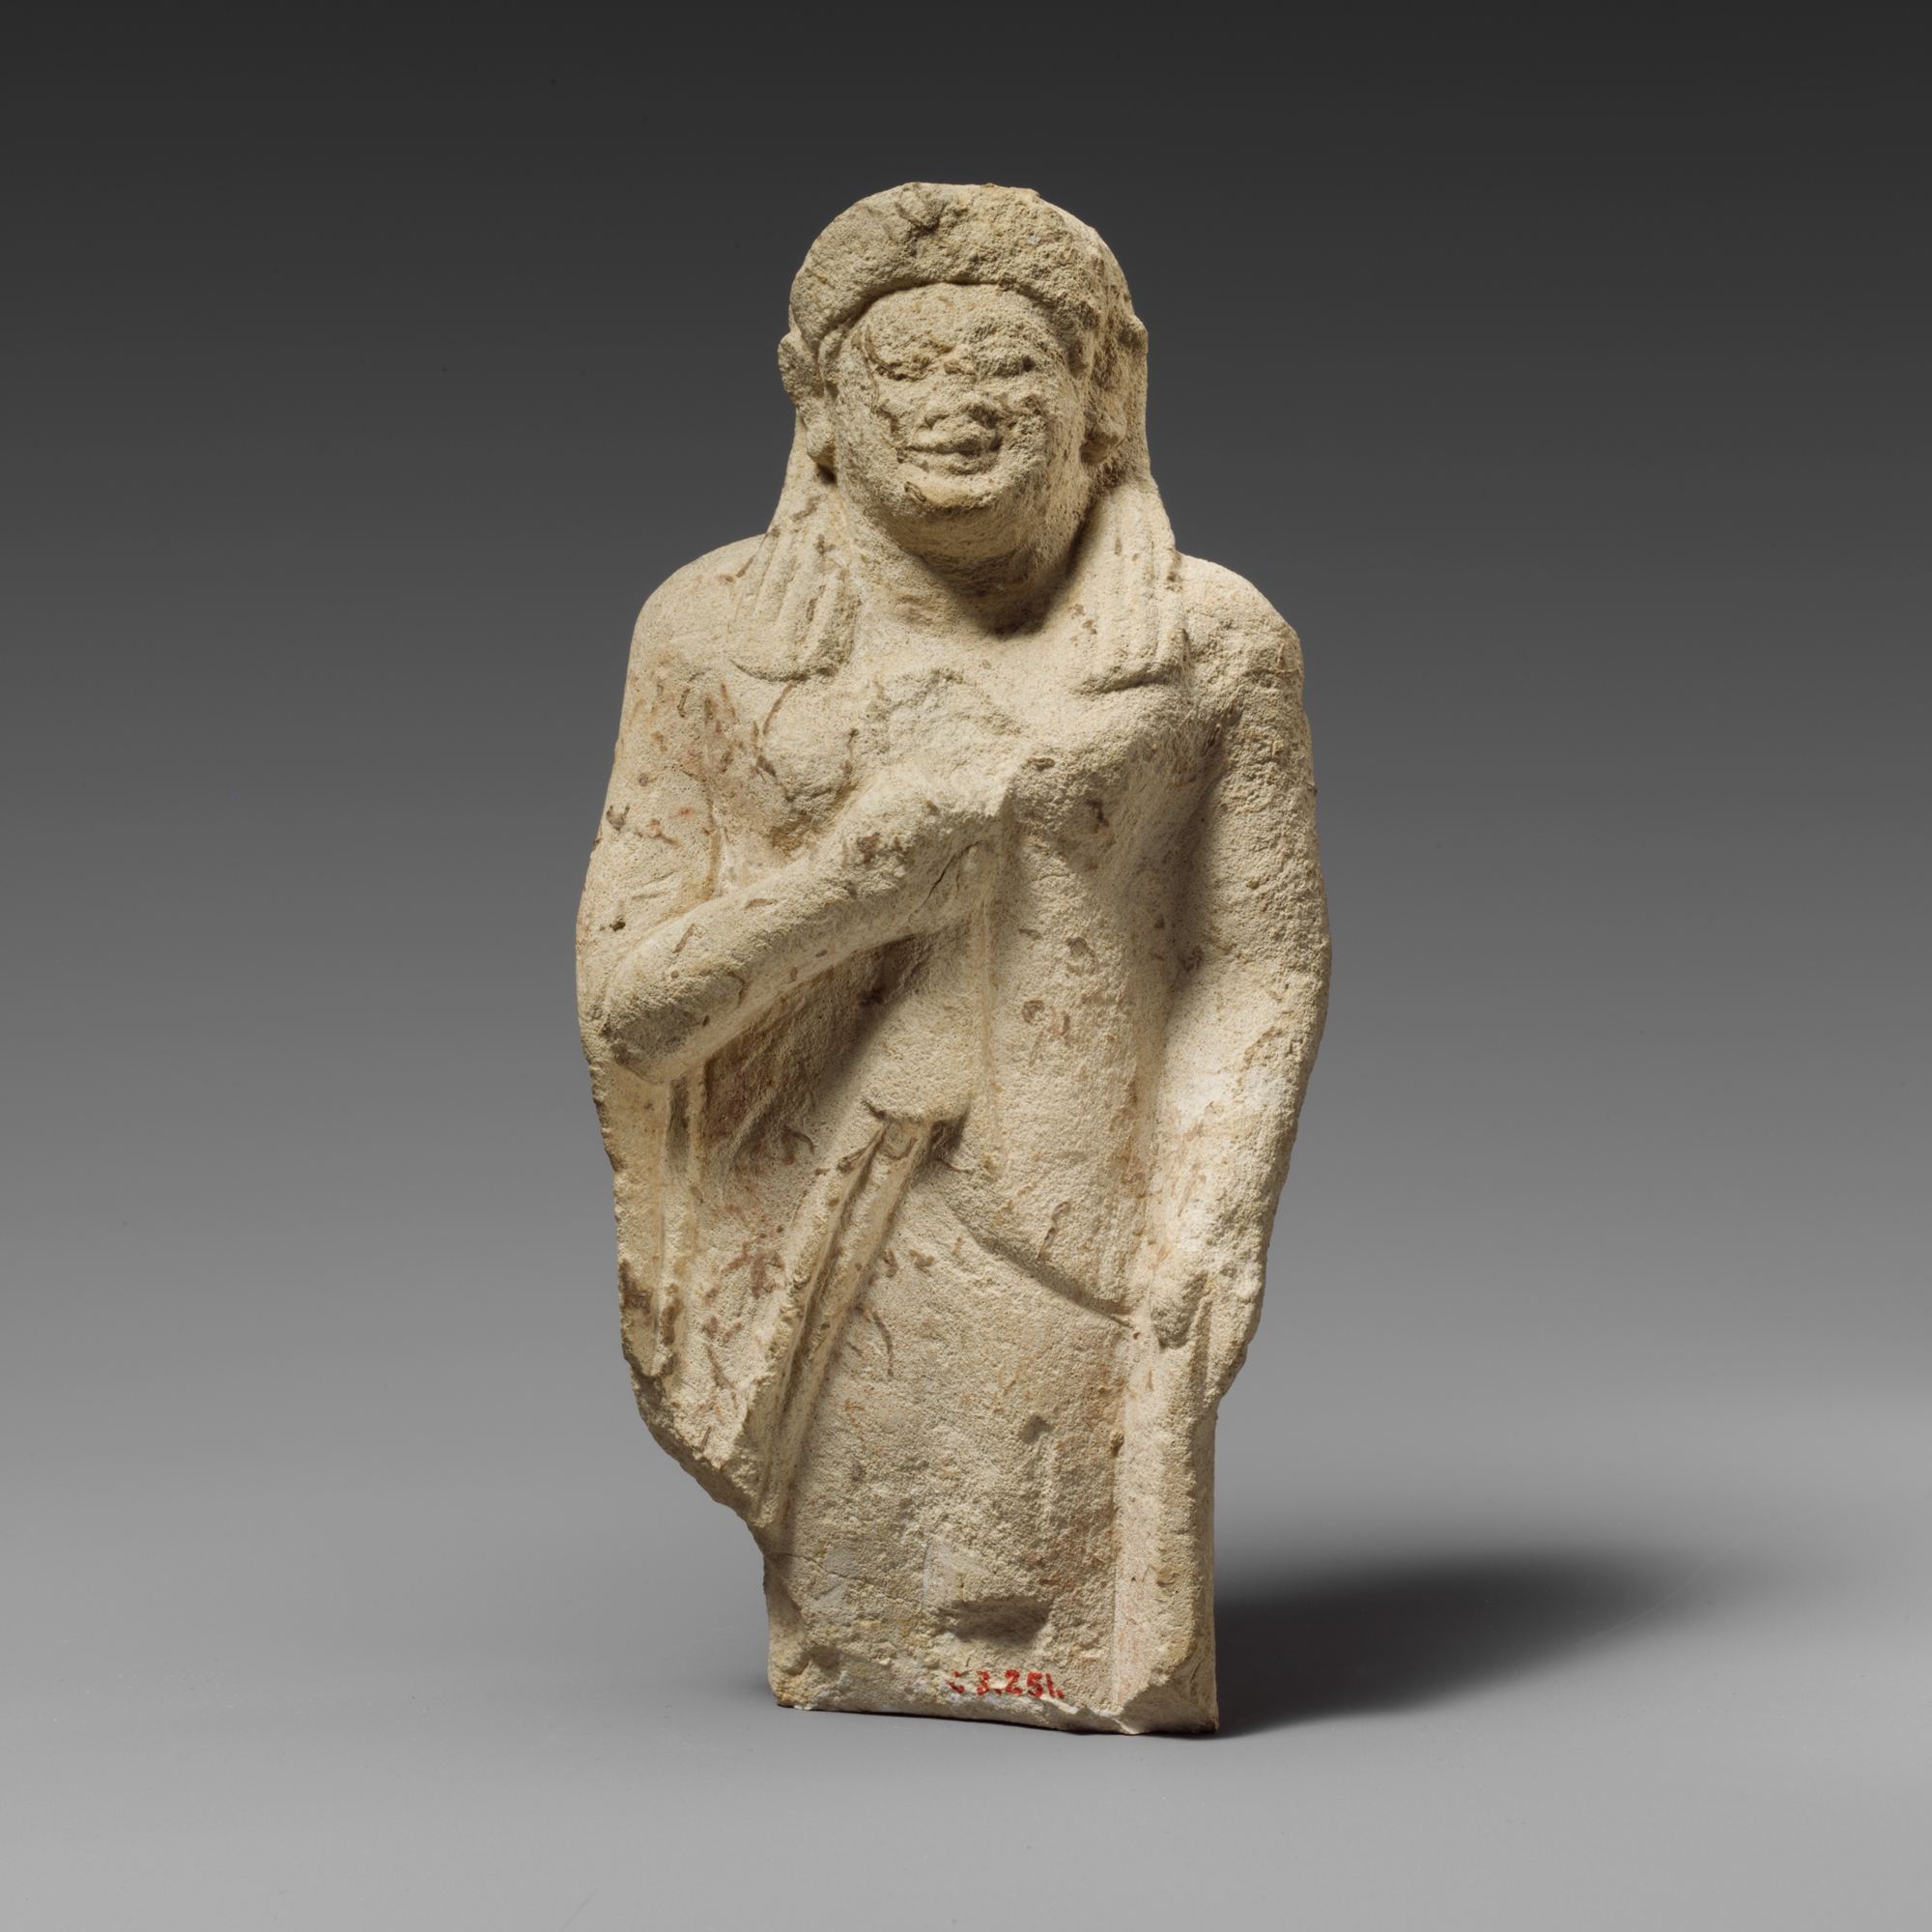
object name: statue of a votary, female, holding a flower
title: Limestone statuette of a female votary of the kore type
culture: cypriot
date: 525-501 BCE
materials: limestone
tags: women